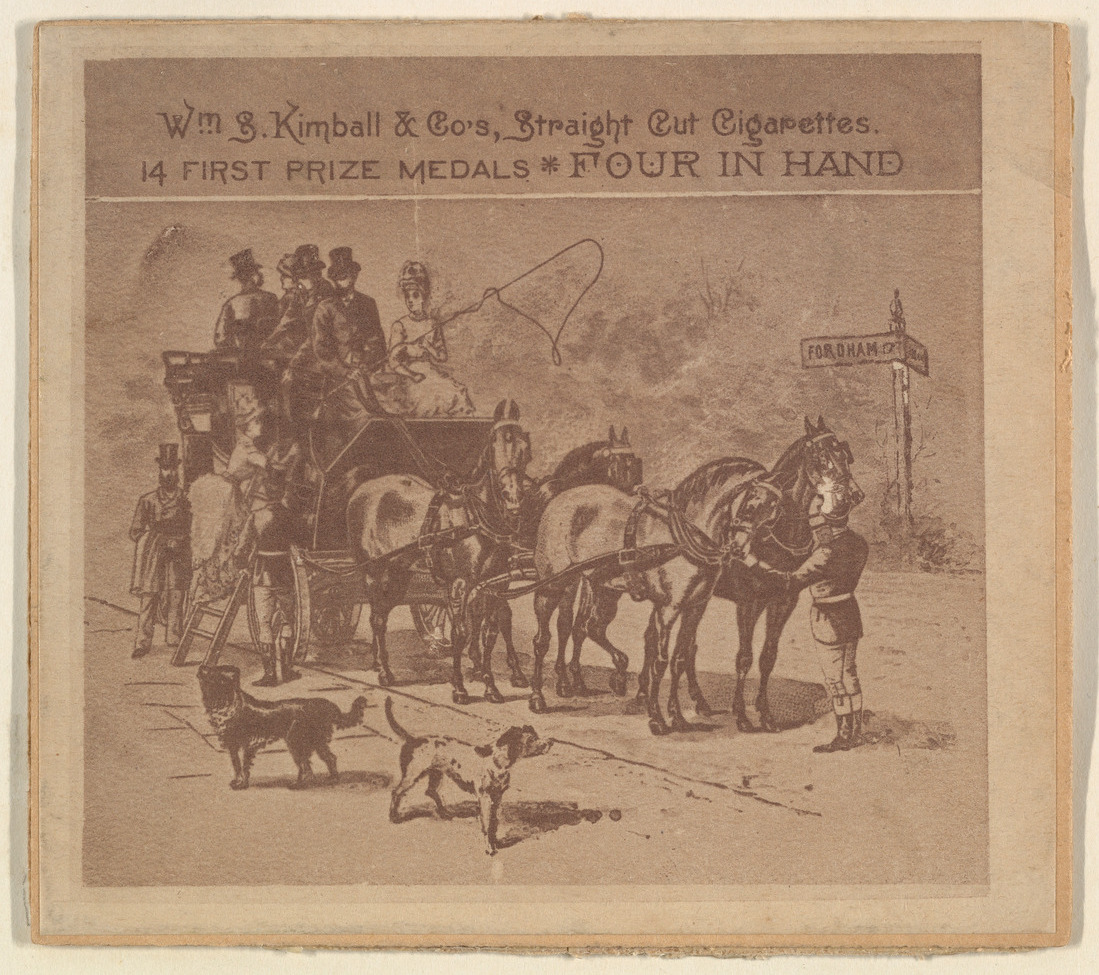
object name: print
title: Four in Hand, from the Sports and Art Subjects series (N197) issued by Wm. S. Kimball & Co.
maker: william s. kimball & company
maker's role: publisher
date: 1889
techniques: color lithograph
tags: men,women,dogs,horses,carriages